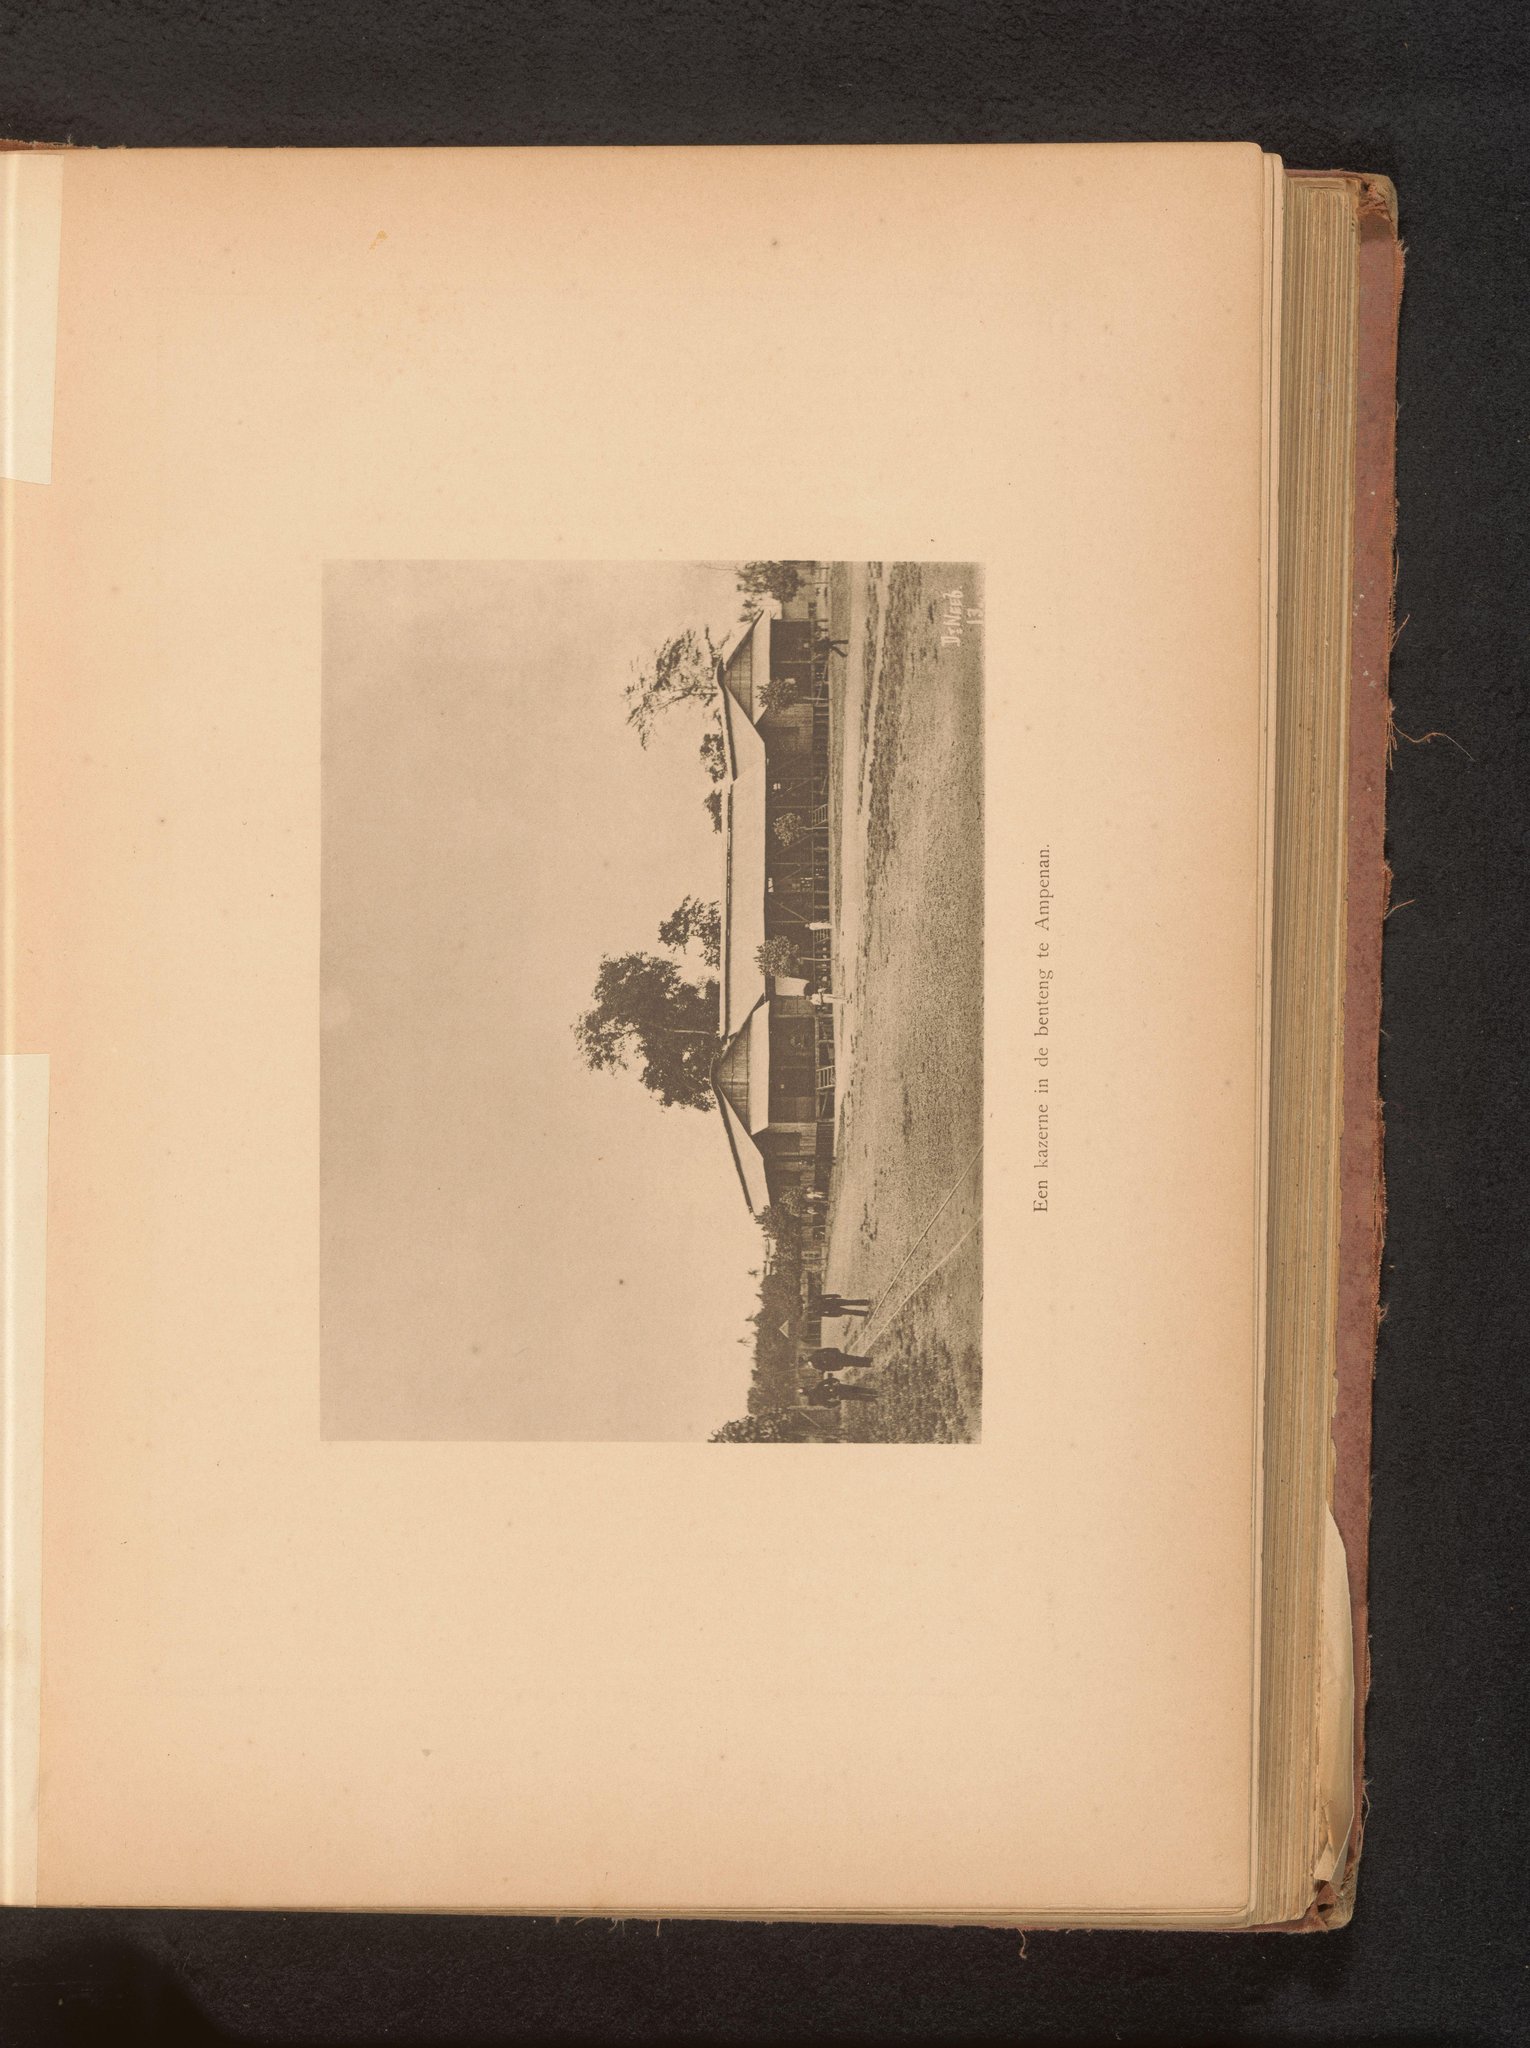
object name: page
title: Een kazerne in de benteng te Ampenan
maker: christiaan johan neeb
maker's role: arts, fotograaf, officier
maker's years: 1860-1925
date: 1892-1897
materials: paper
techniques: photograph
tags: other dwelling types